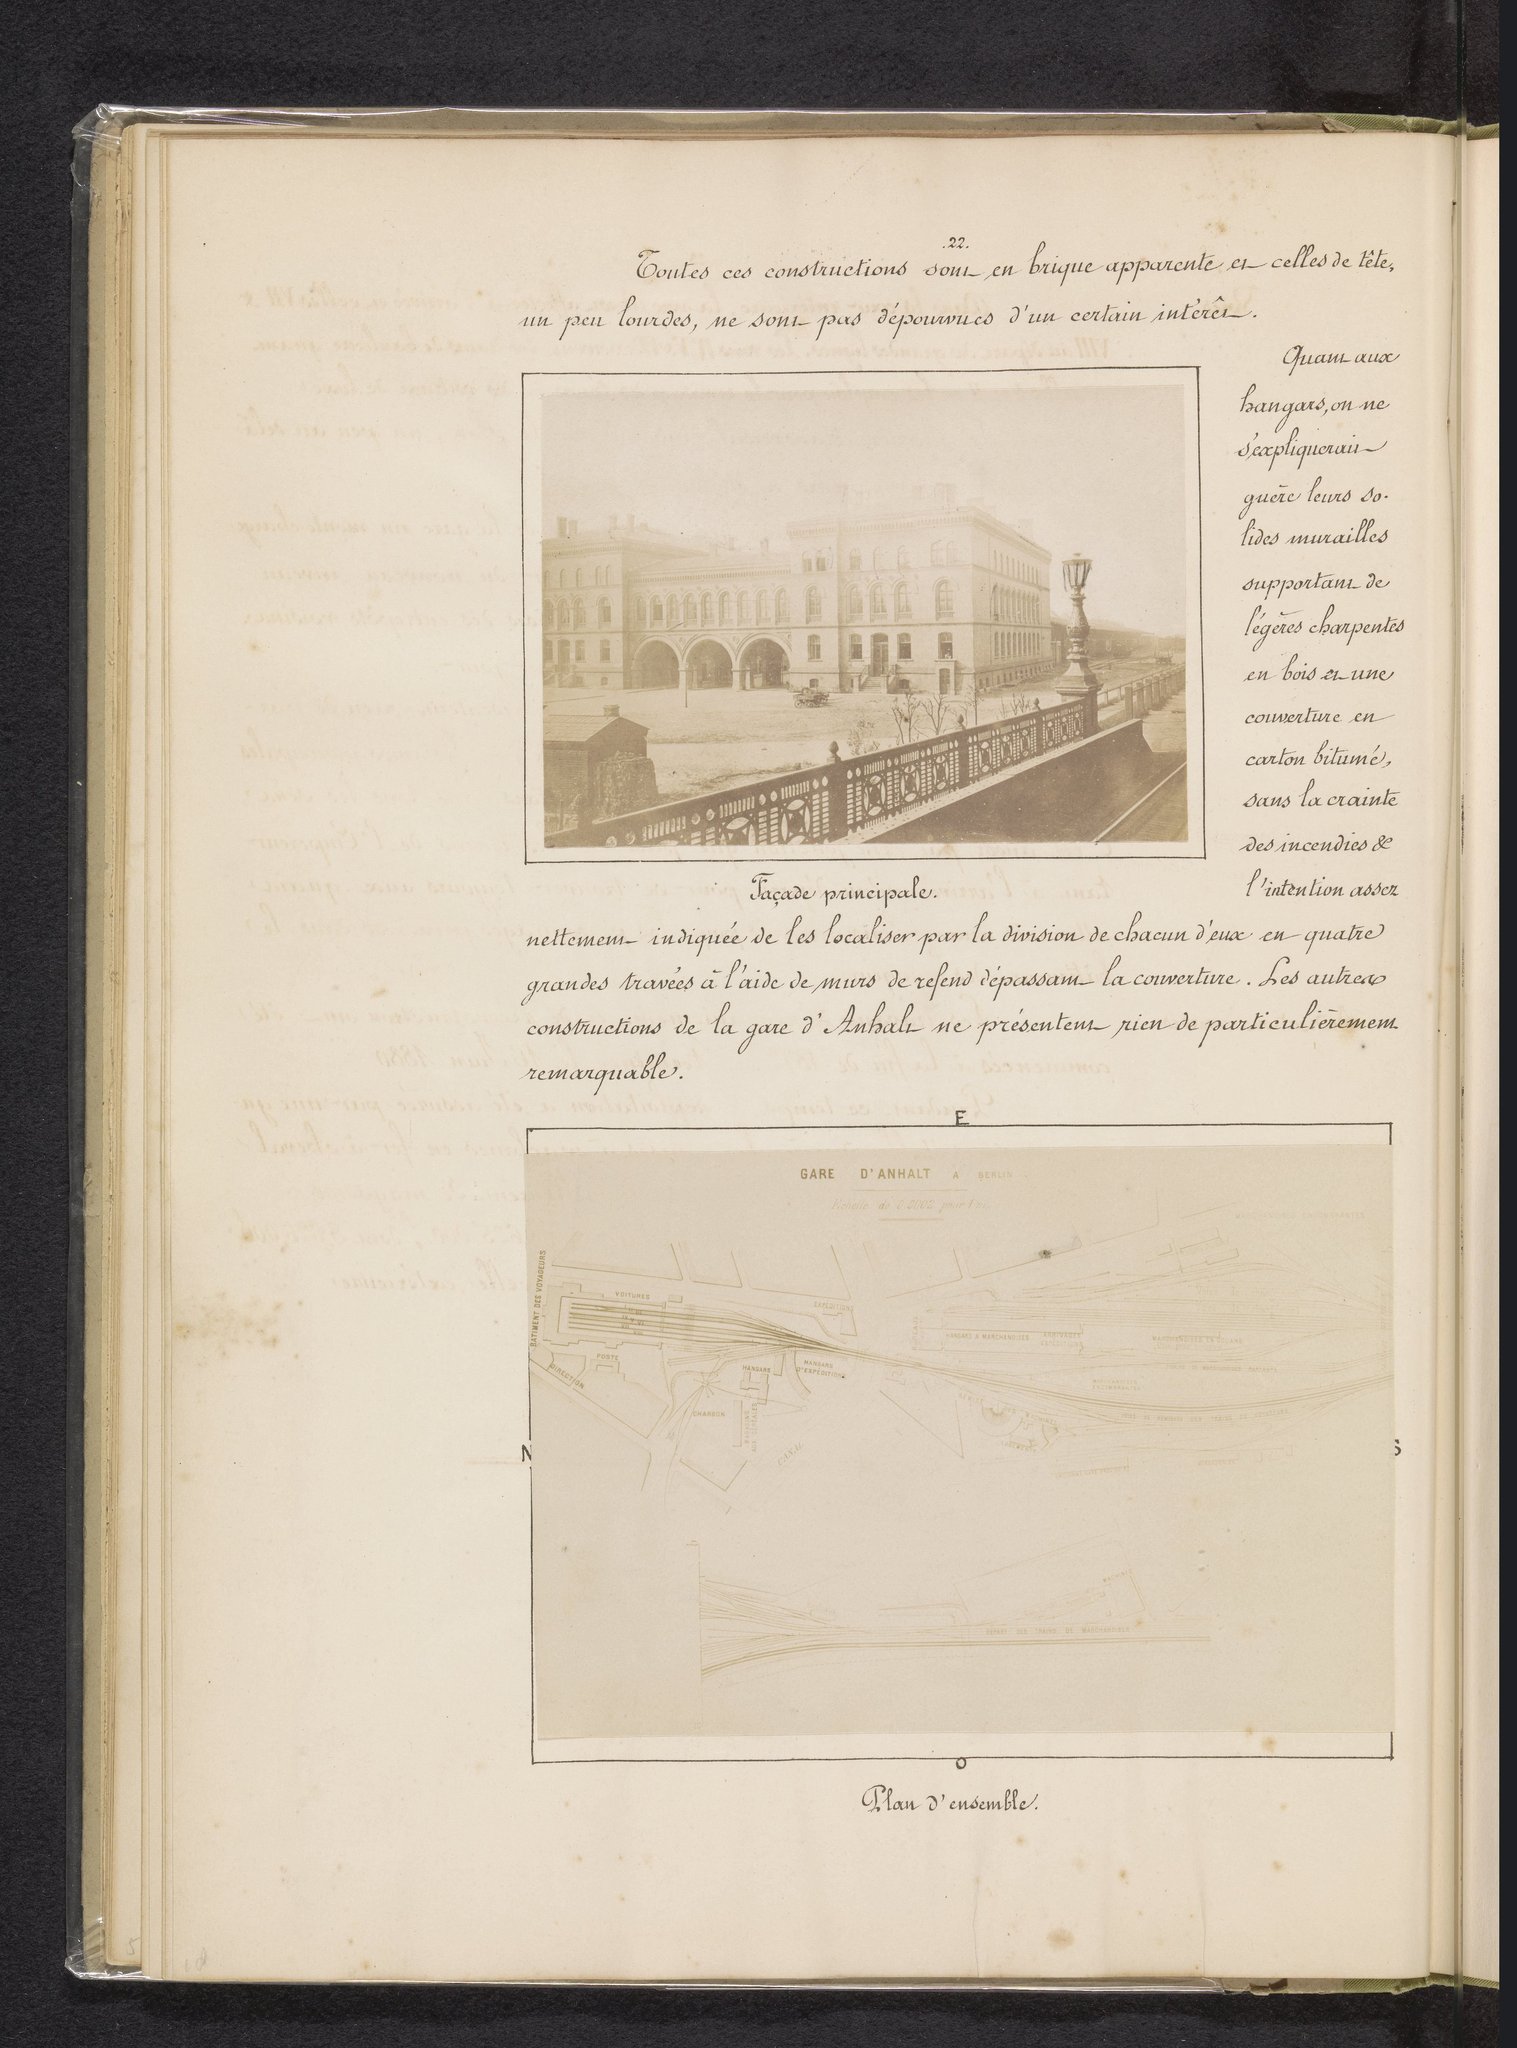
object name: photograph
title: Plan d'ensemble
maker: Anonymous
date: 1874-1884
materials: photographic support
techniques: albumen print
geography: berlin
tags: maps, atlases, railway, train, façade (of house or building), station; shelter (railway, tramway)